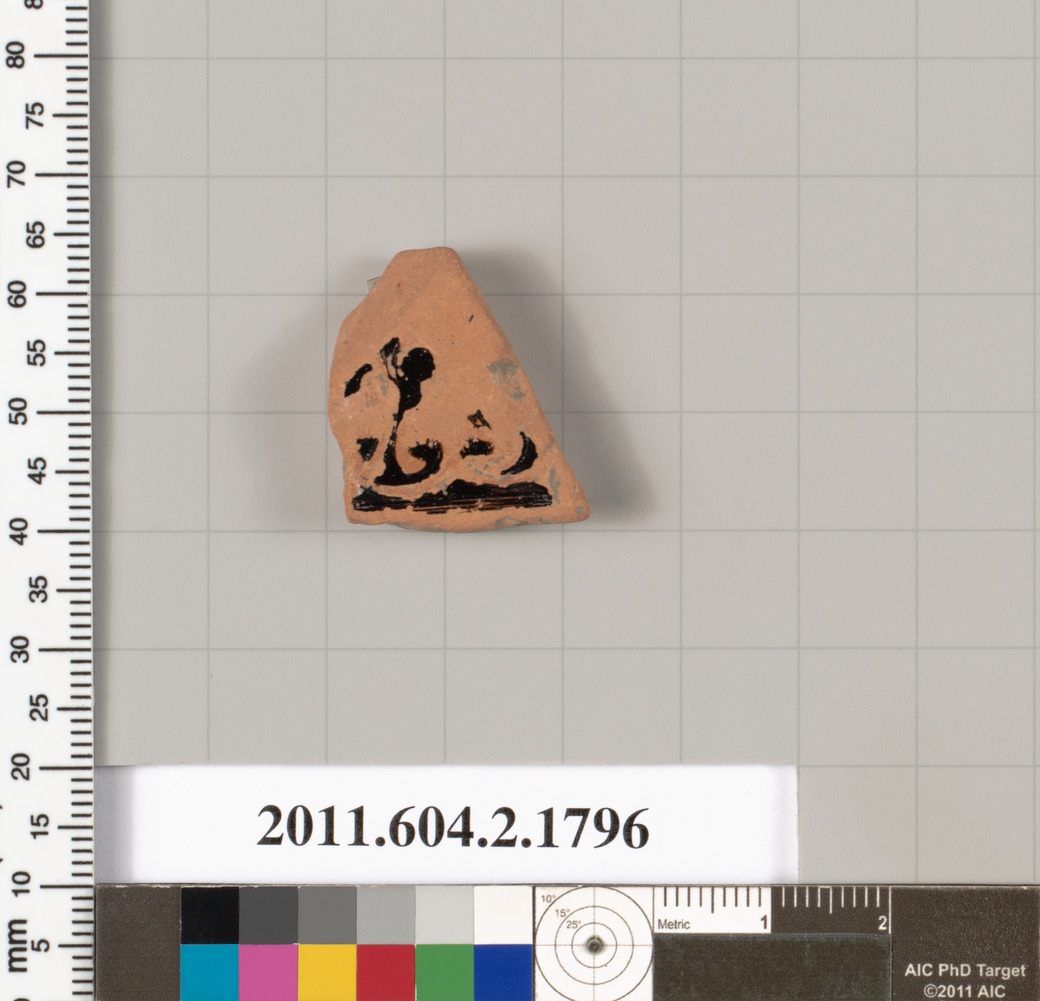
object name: skyphos fragment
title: Terracotta fragment of a skyphos (deep drinking cup)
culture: greek, attic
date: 467-435 BCE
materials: terracotta